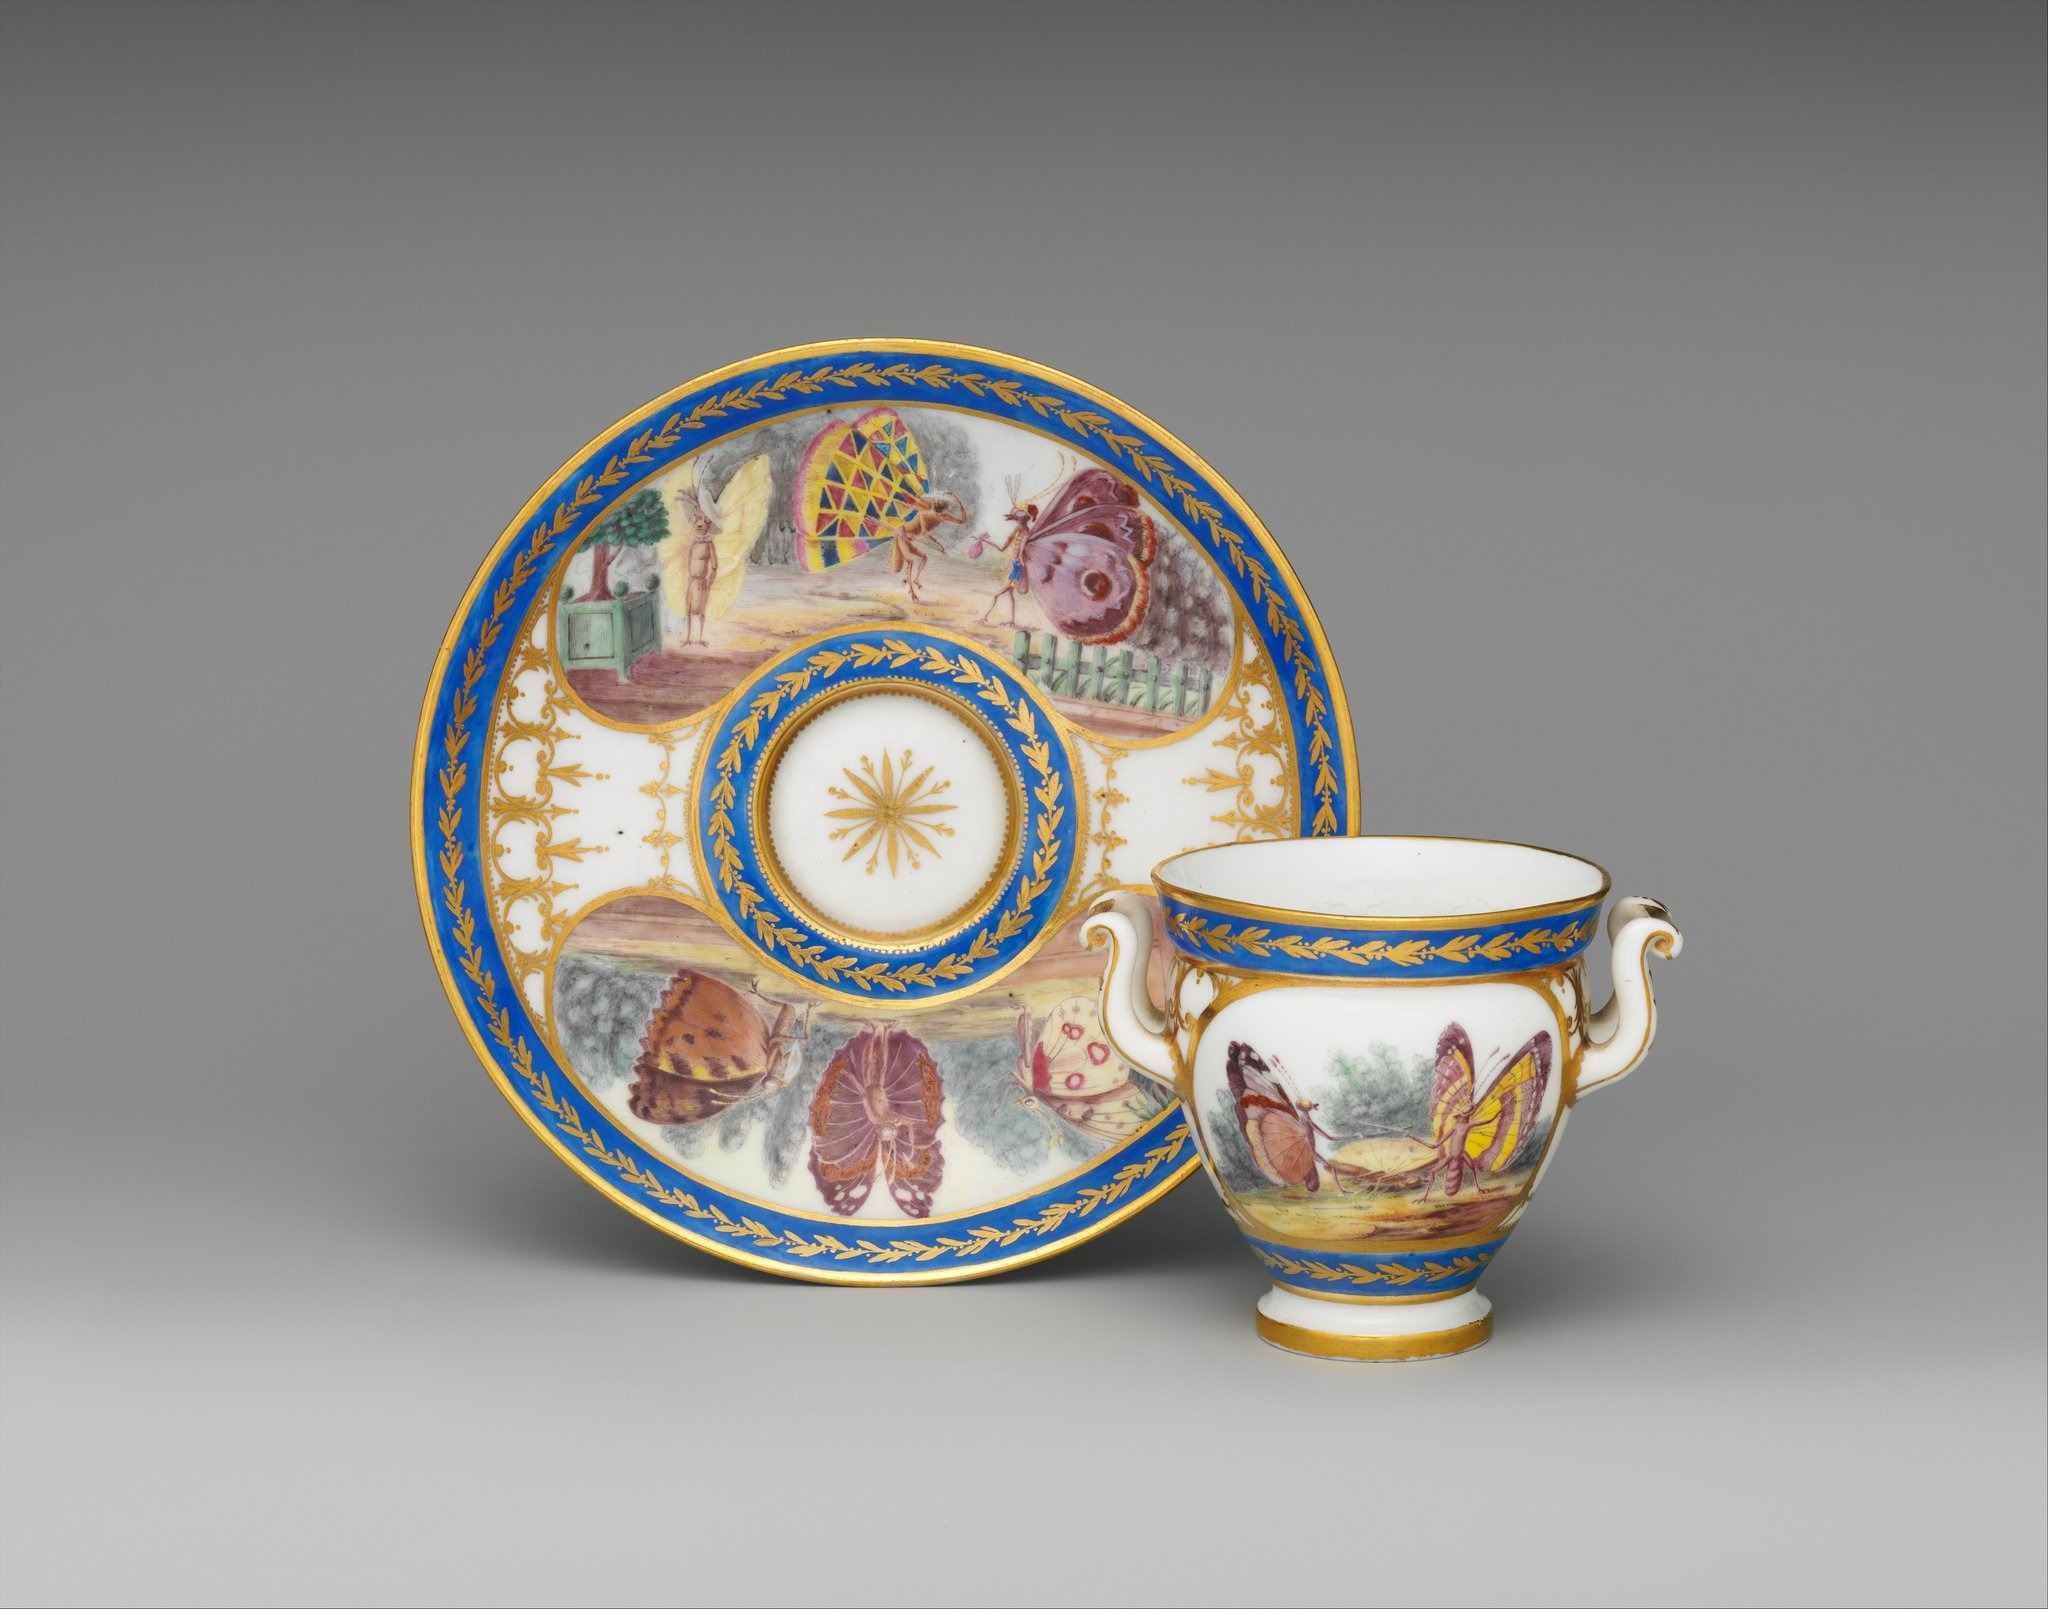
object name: cup and saucer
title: Cup (tasse à l'étrusque) and saucer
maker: sèvres manufactory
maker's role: manufactory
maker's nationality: french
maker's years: 1740-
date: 1794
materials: soft paste porcelain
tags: butterflies